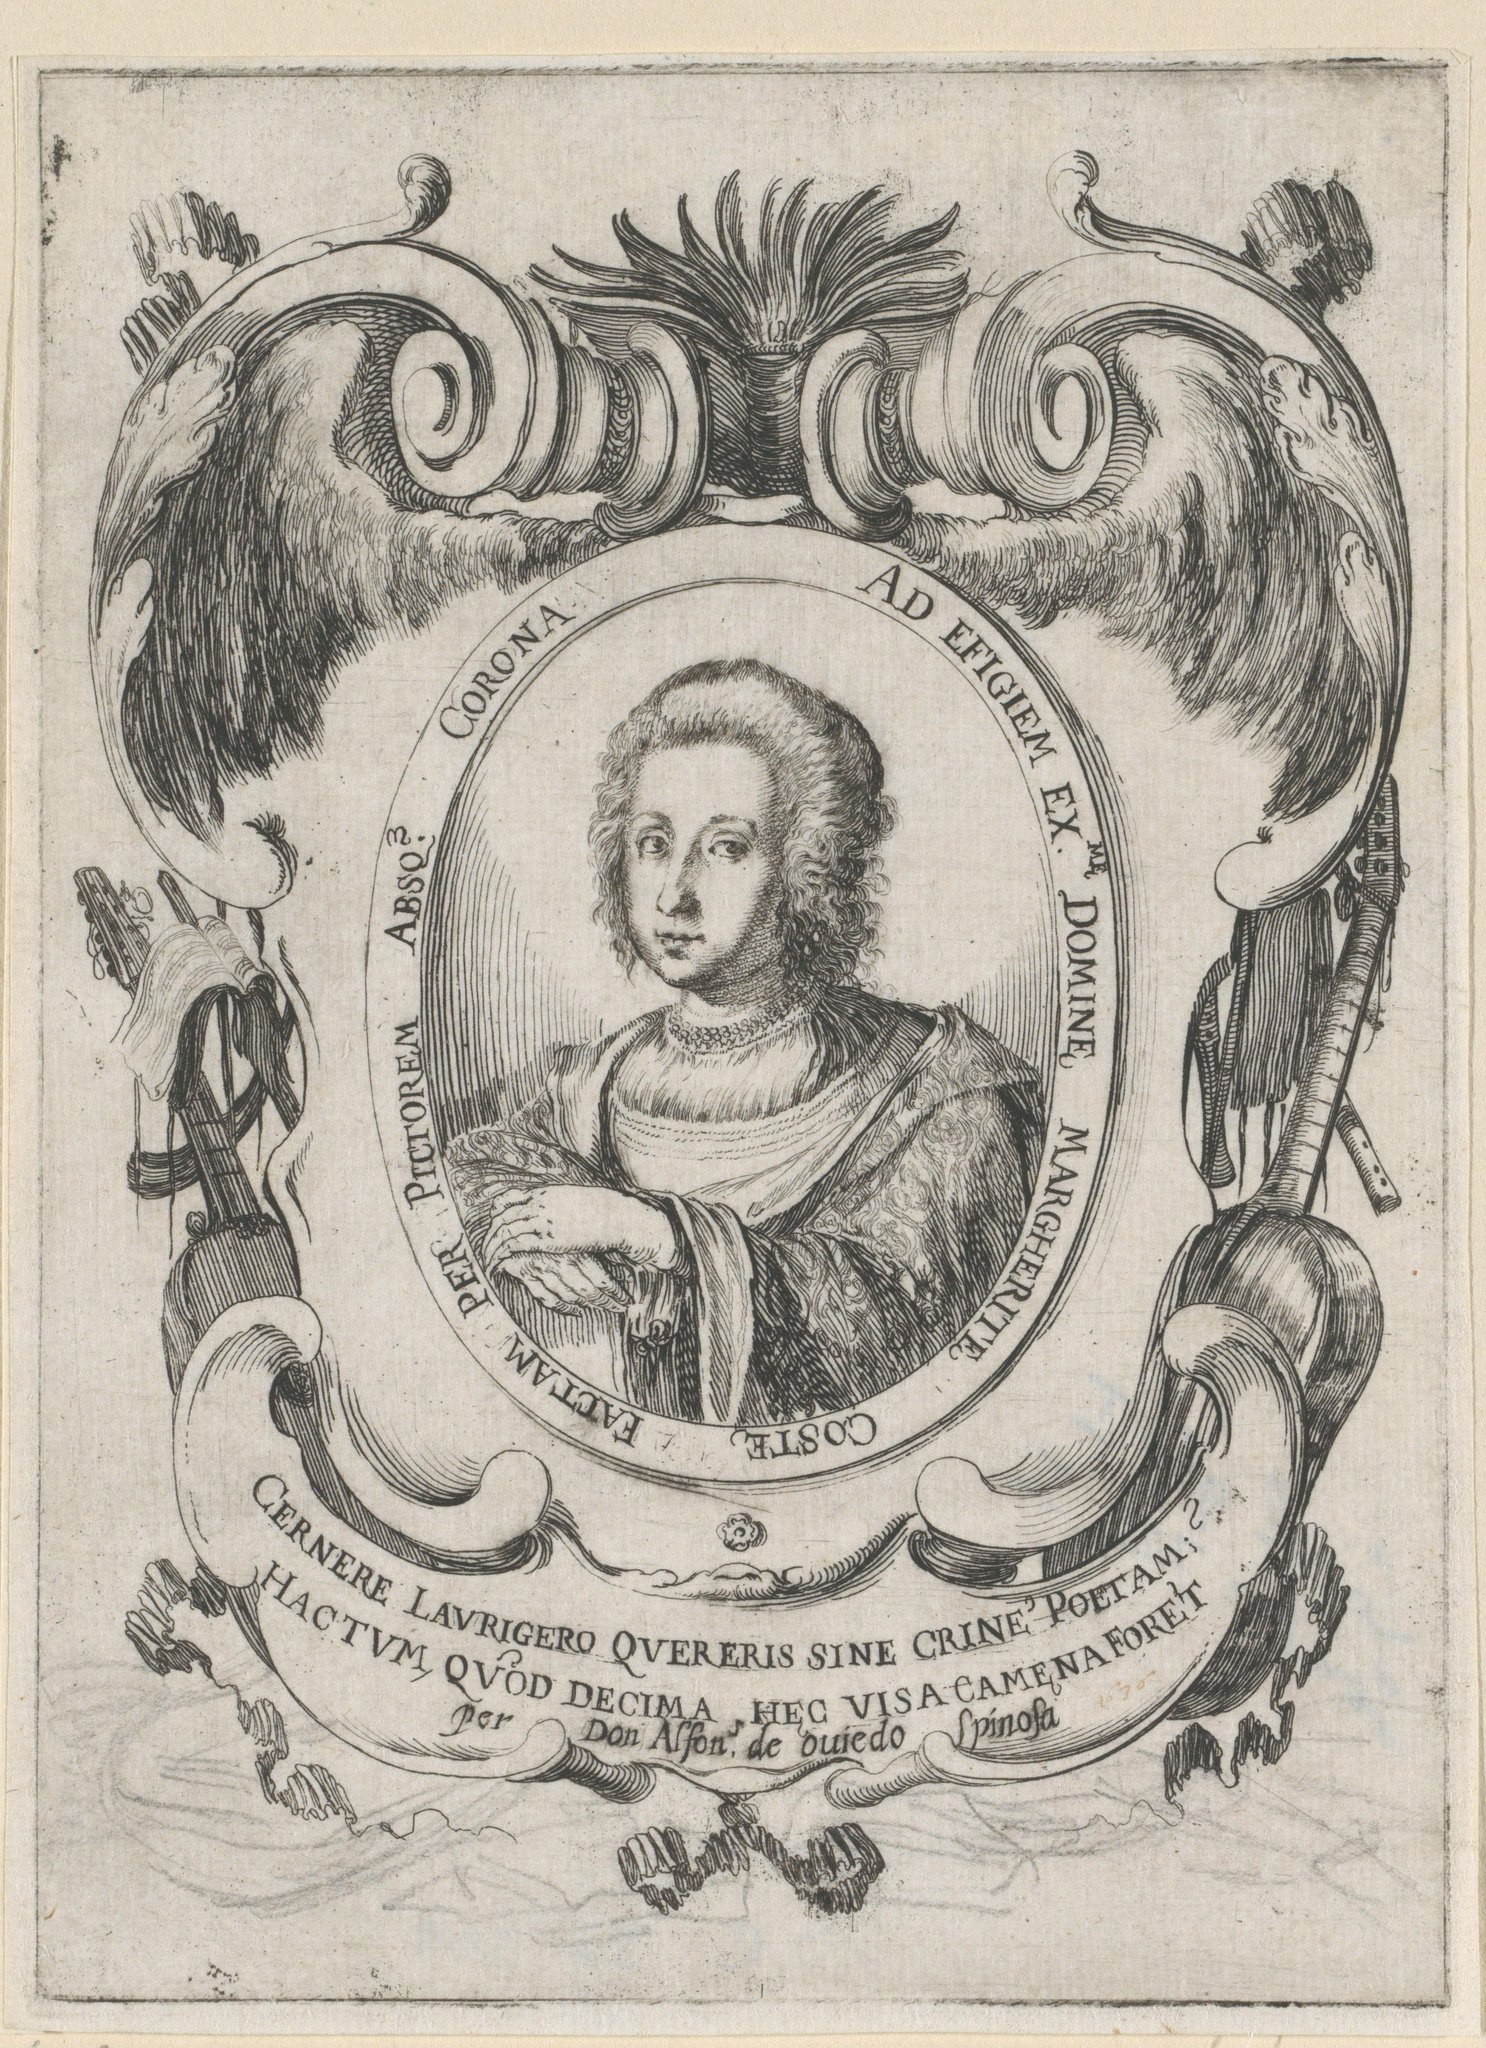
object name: print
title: Portret van Marguerite Costa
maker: stefano della bella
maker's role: draughtsman, print maker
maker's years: 1610-1664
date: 1620-1664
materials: paper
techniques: etching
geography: italy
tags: historical persons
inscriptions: collector's mark: Lugt 240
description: Getekende voorstudie wordt bewaard in de Galleria degli Uffizi te Florence (inv. nr. 623 ORN).